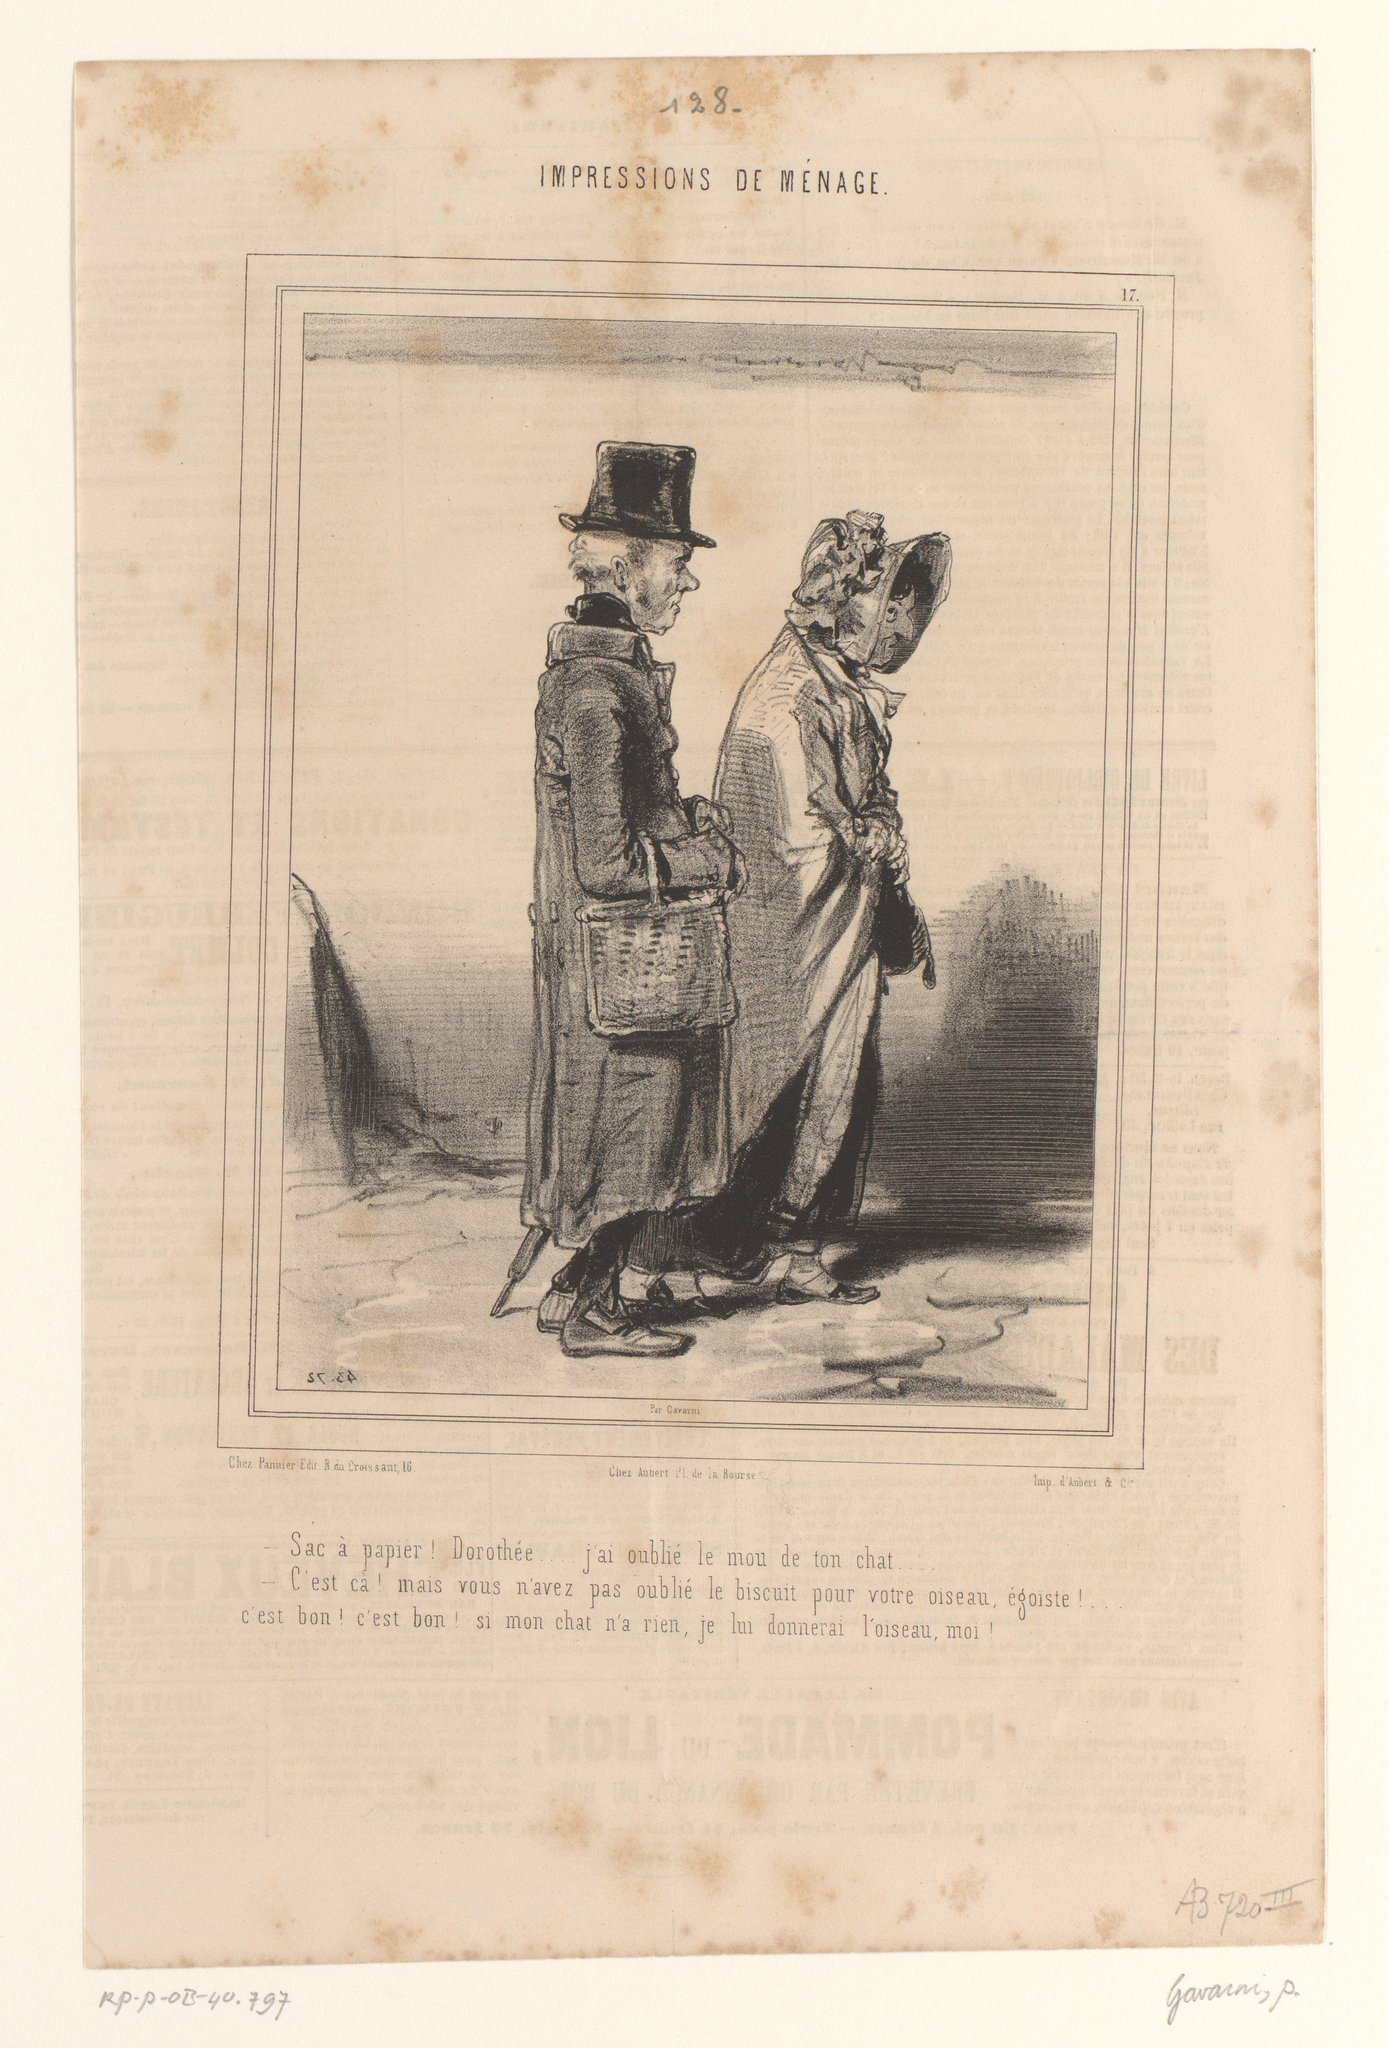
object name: print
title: Oud echtpaar wandelt kibbelend op straat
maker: paul gavarni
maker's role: draughtsman, print maker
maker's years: 1804-1866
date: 1843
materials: paper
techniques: lithograph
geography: paris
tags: old man, old woman, walking, man and wife quarrelling, 'marriage à la mode', satire on marriage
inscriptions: collector's mark: Lugt 2228a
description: De man is het eten voor de kat van zijn vrouw vergeten.